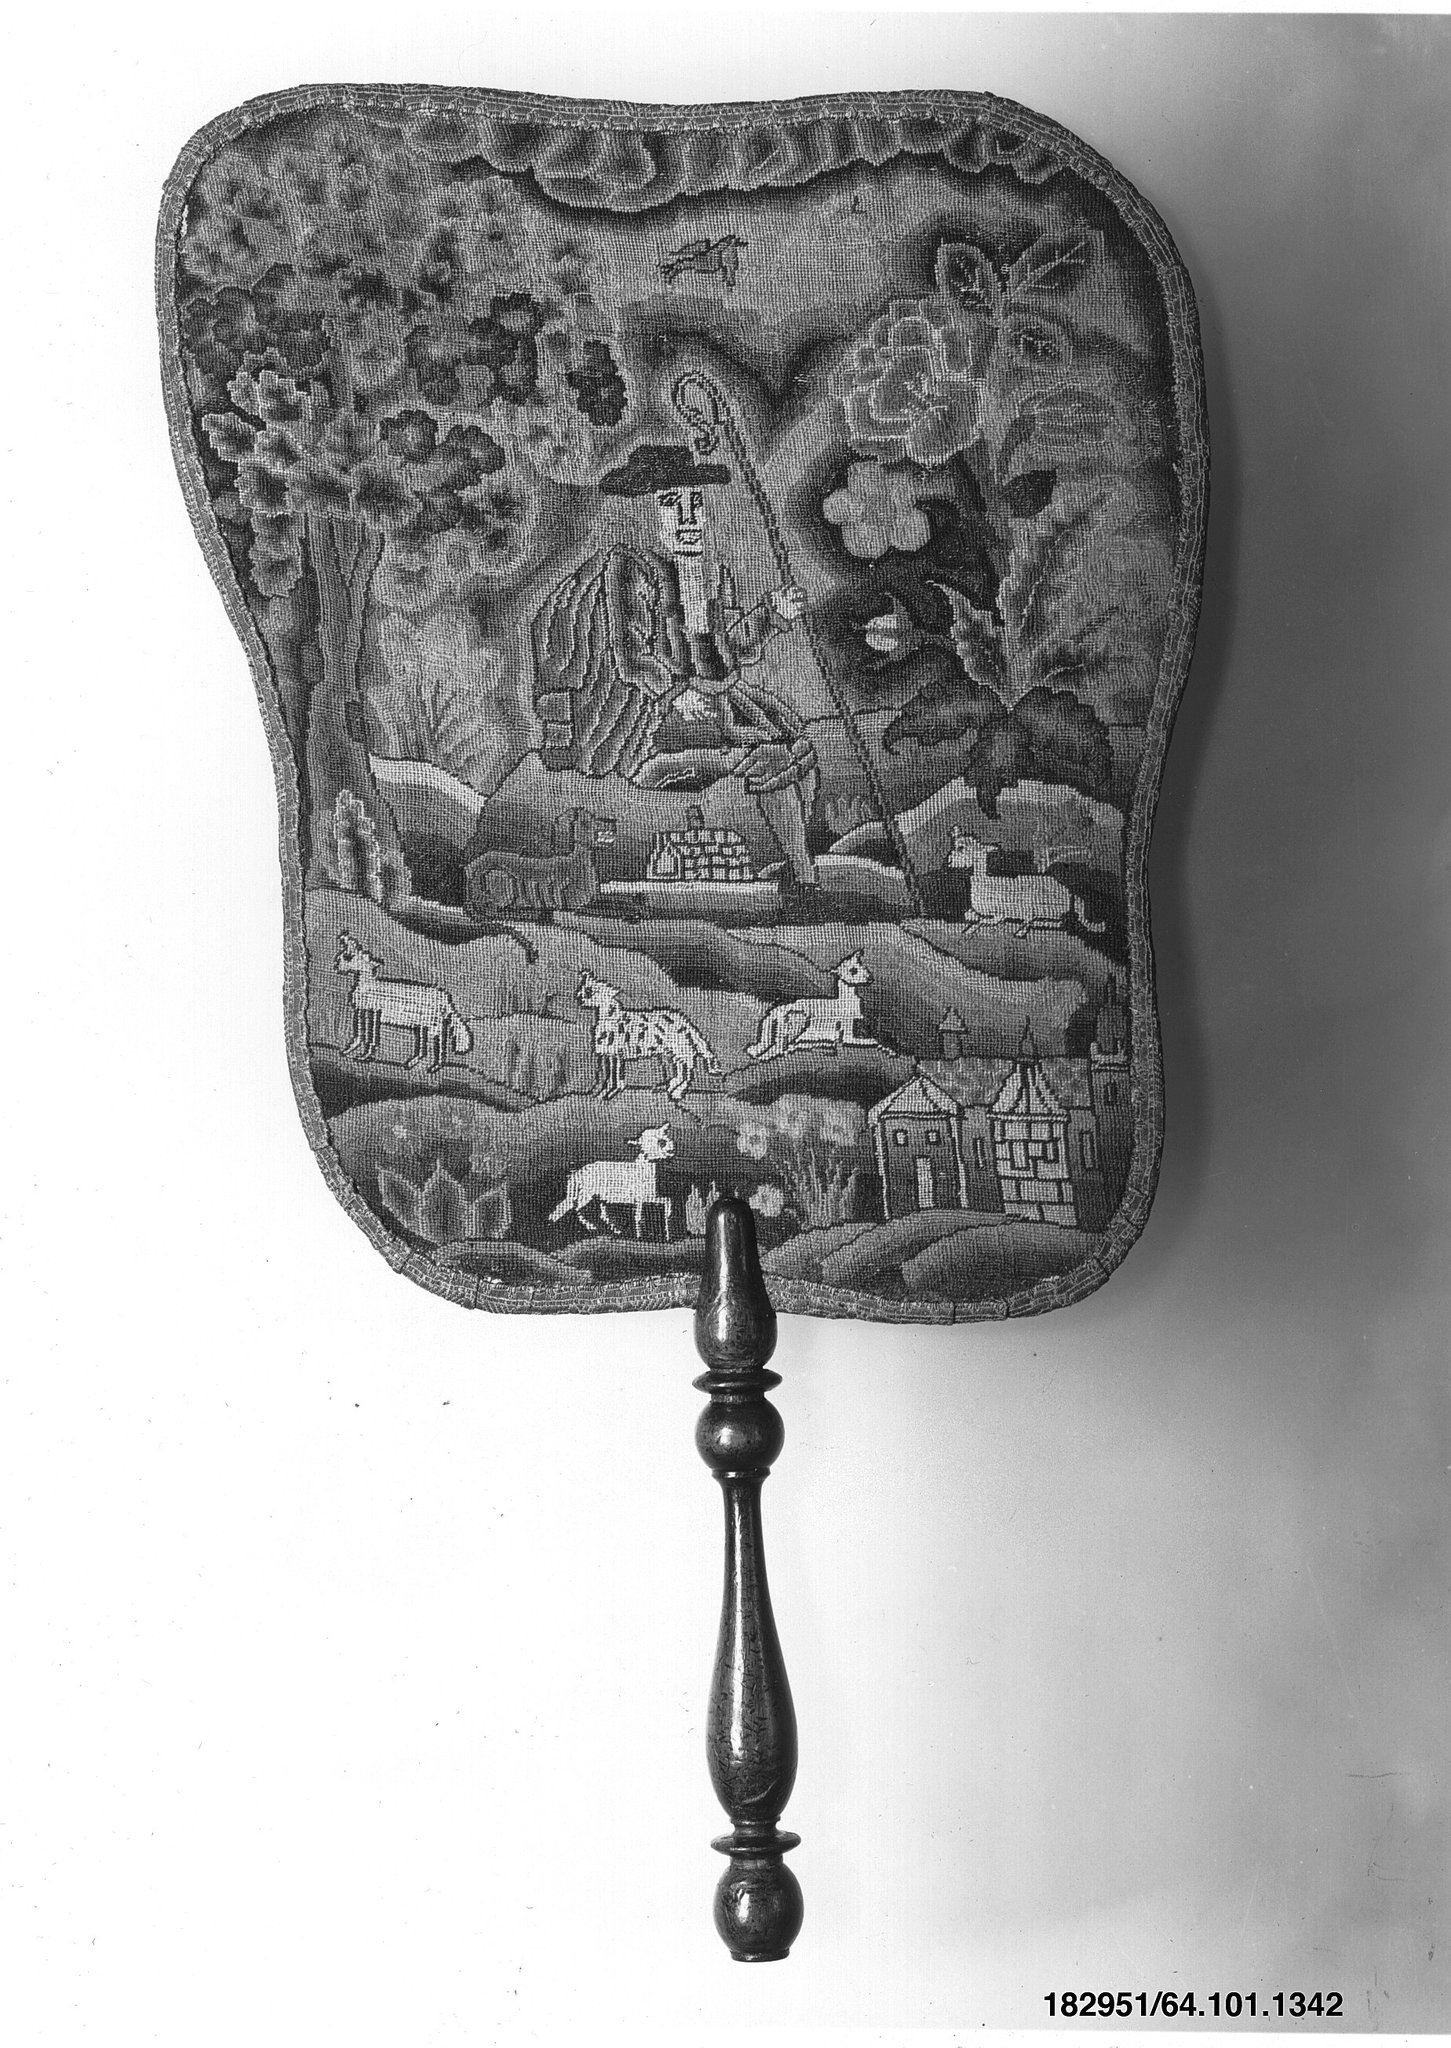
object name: hand screen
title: Pair of hand screens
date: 1701-1725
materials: canvas, silk, wool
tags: animals,men,women,flowers